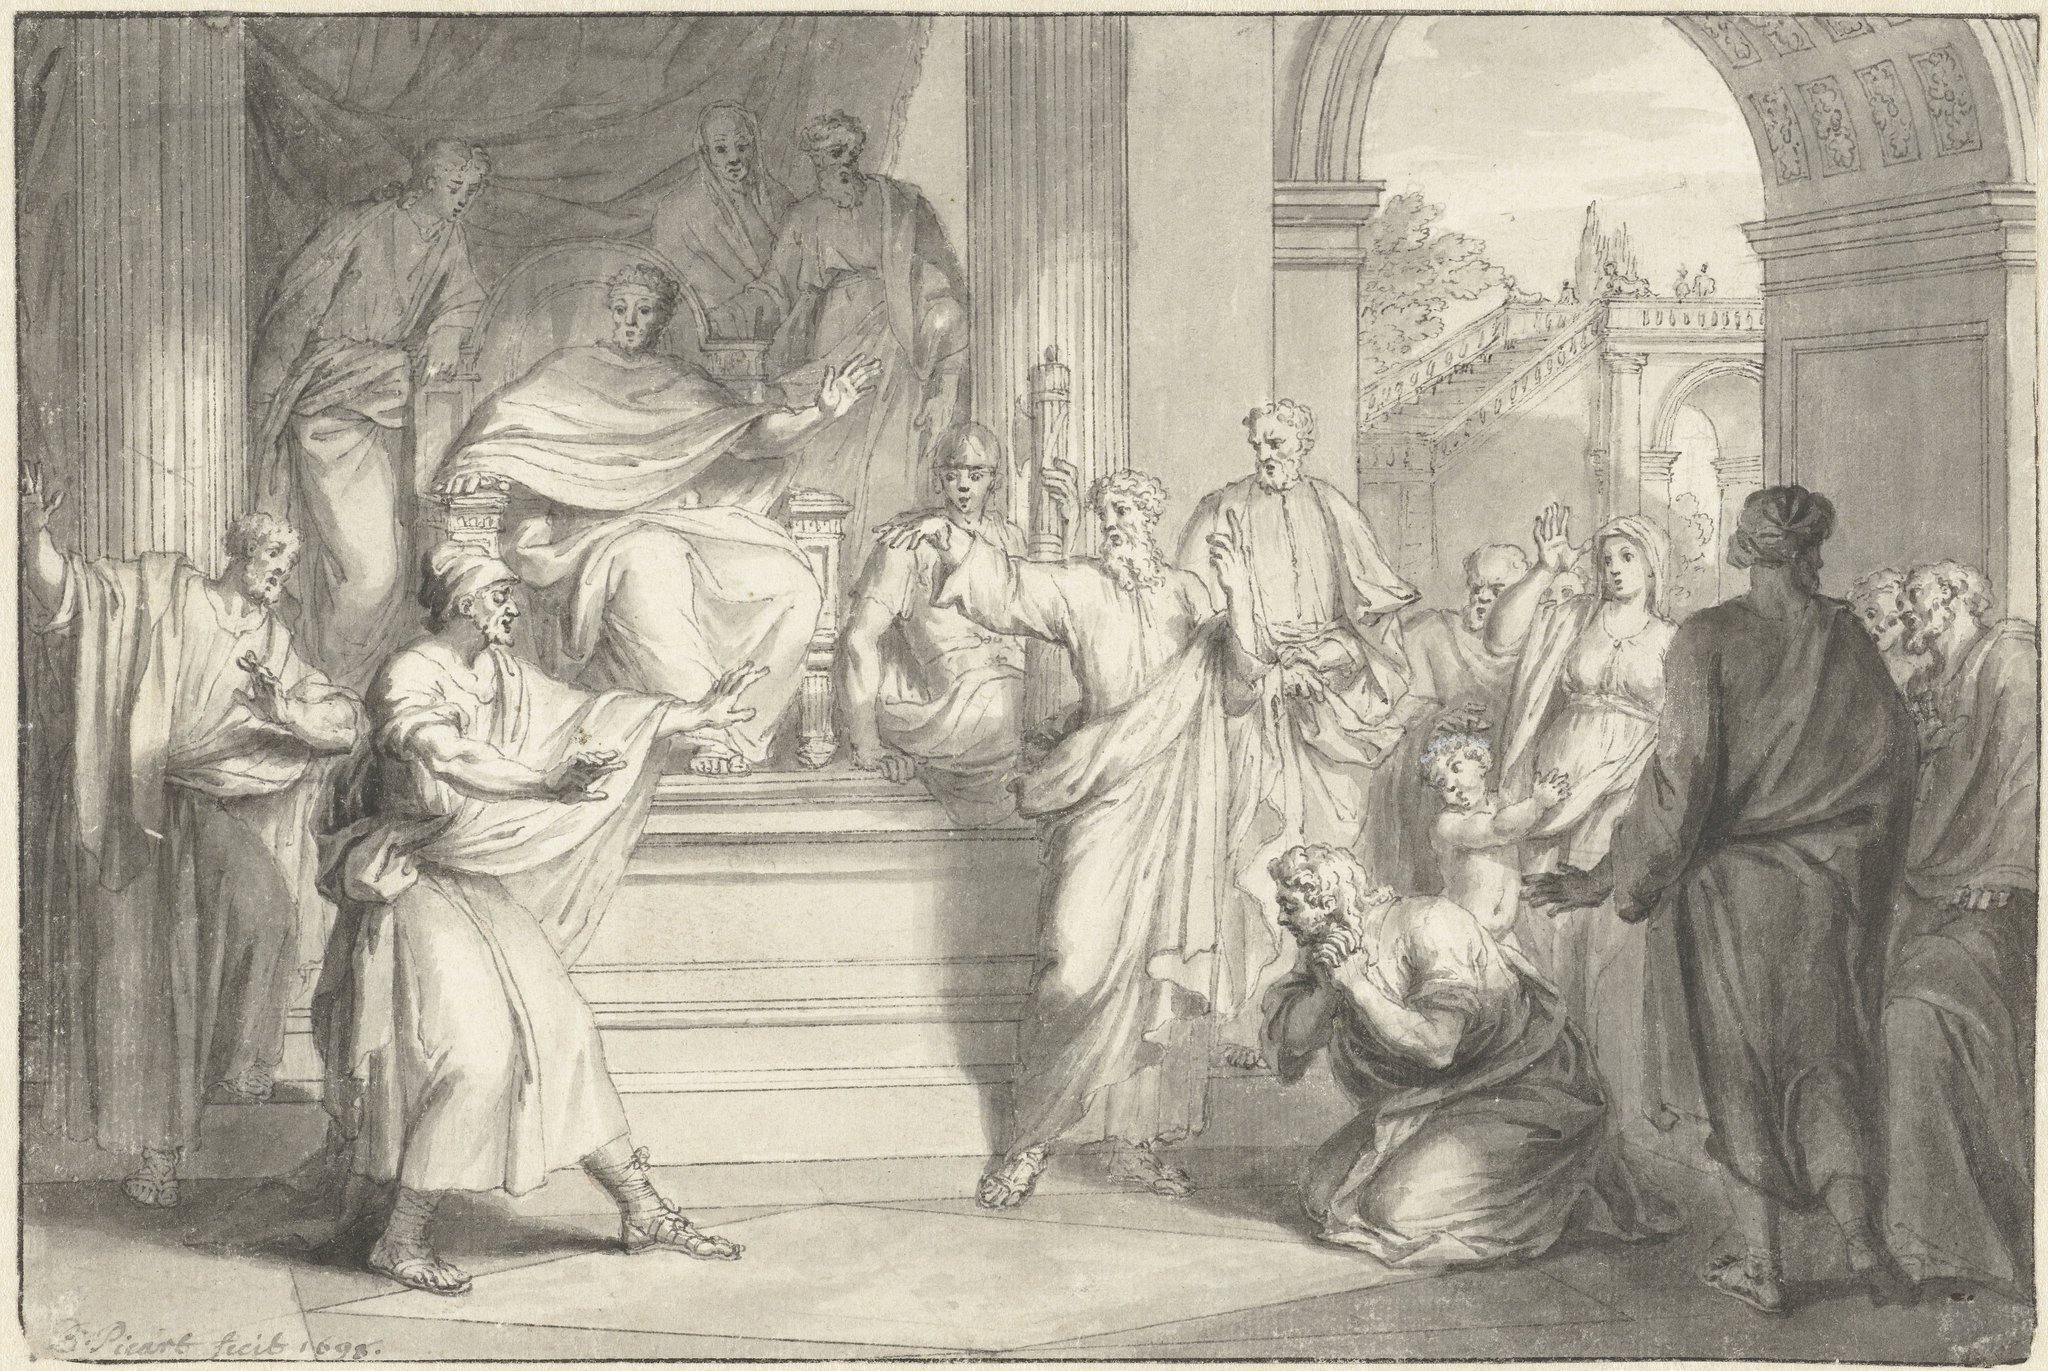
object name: design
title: Paulus slaat de tovenaar Elymas met blindheid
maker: bernard picart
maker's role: draughtsman, print maker, publisher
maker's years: 1673-1733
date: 1698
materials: ink, paper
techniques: brush, pen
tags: the sorcerer elymas (elymes, bar-jesus), who tries to prevent paul and barnabas from speaking, is struck blind by paul